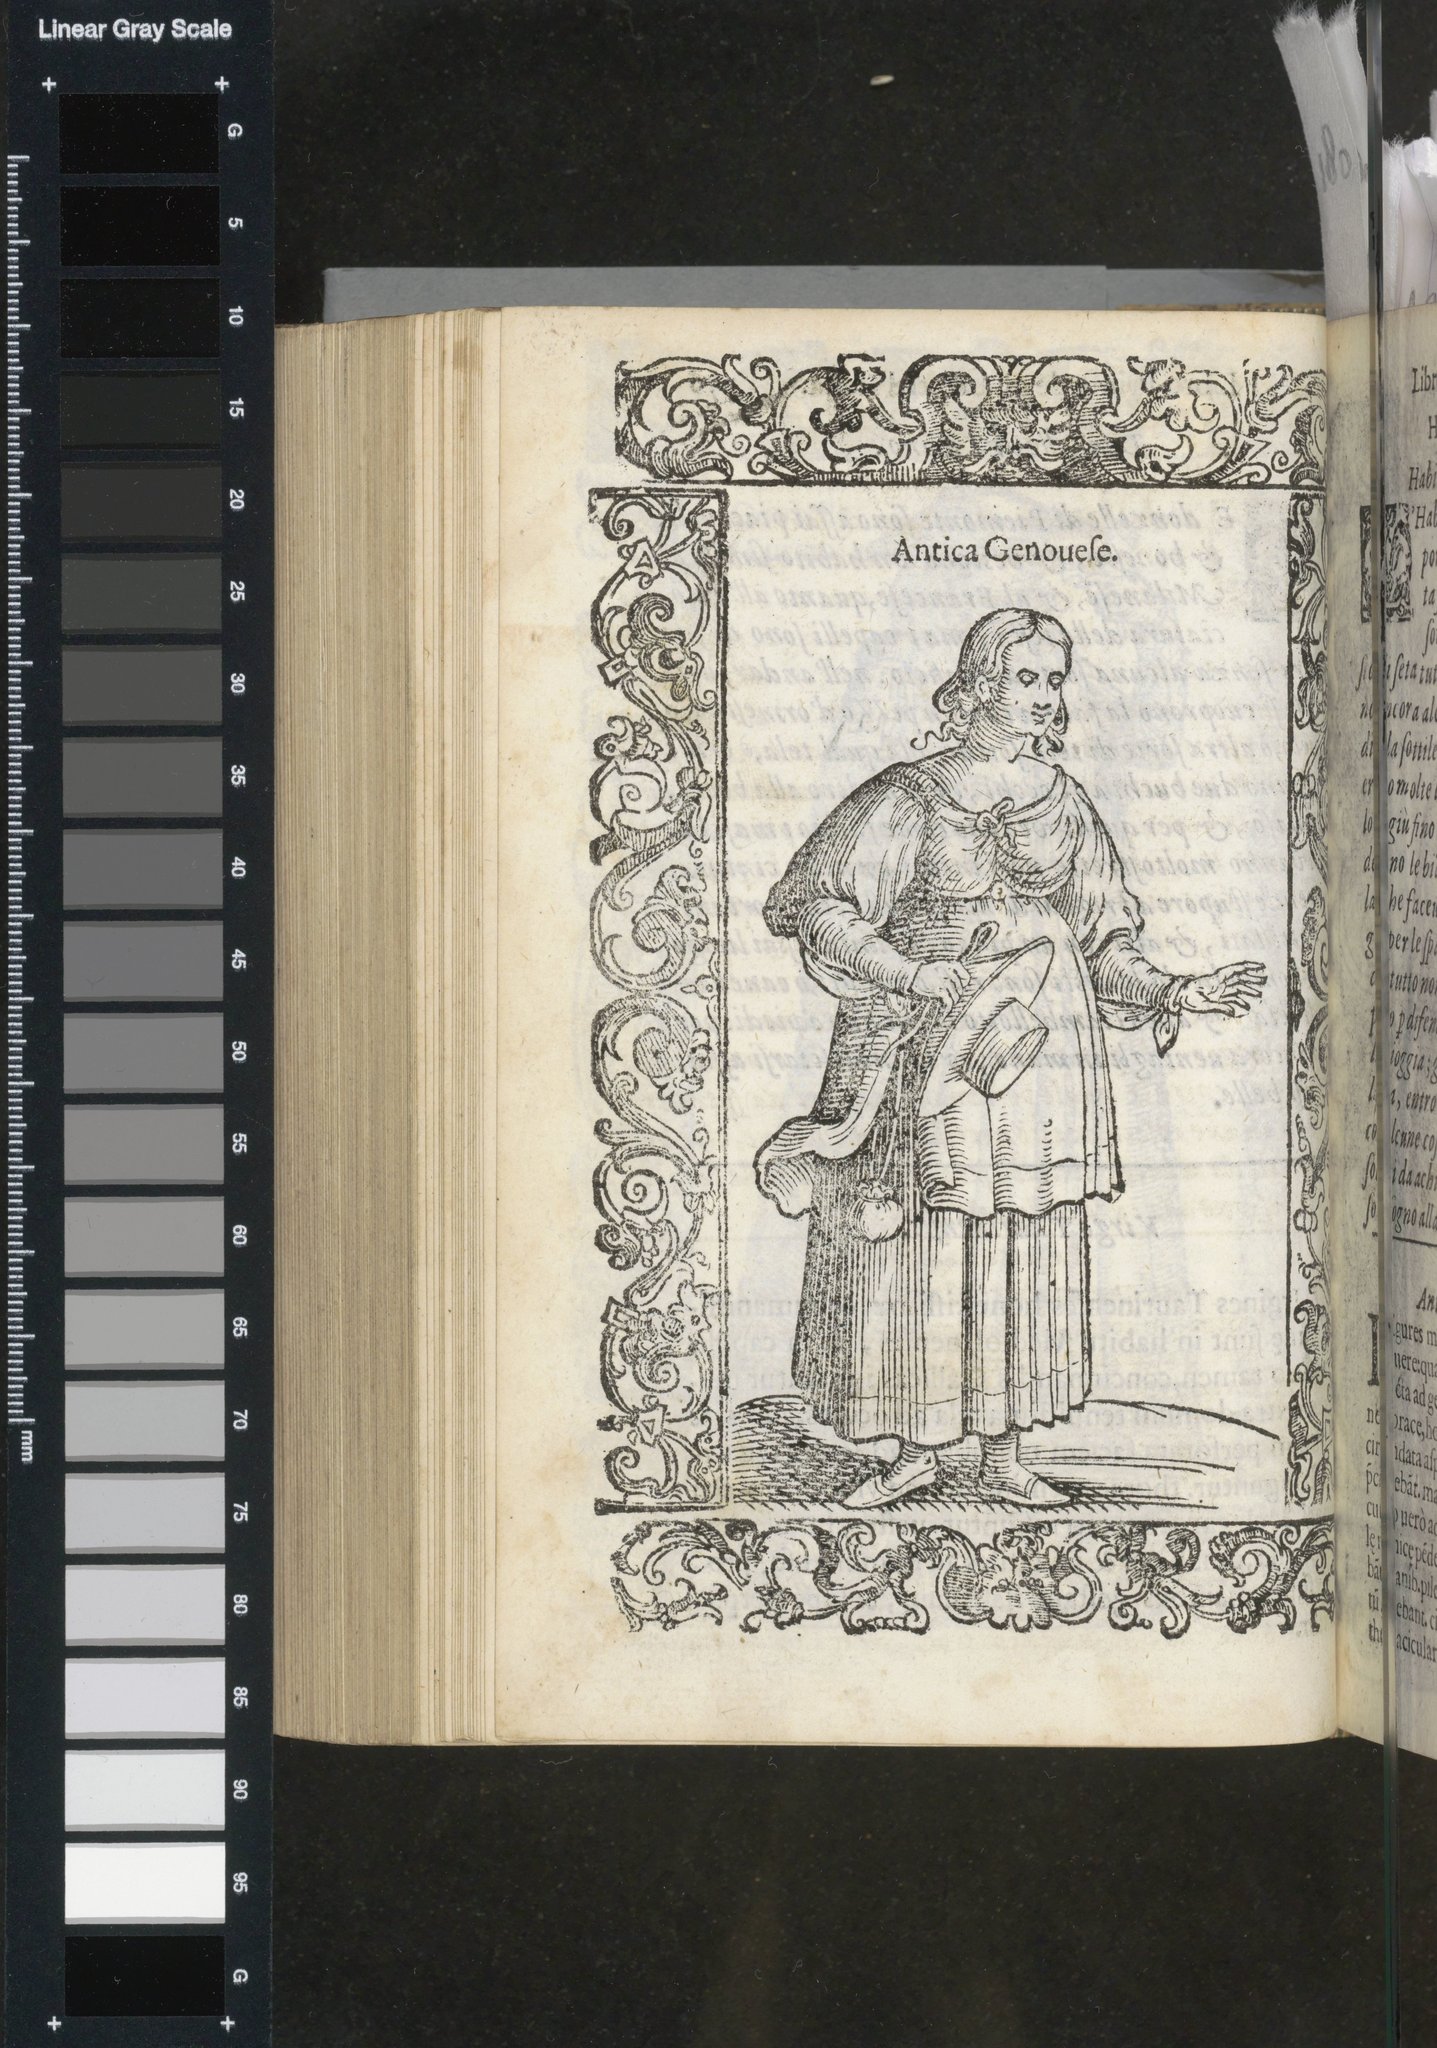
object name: costume print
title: Antica Genovese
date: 1598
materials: paper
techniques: woodcut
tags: fashion plates